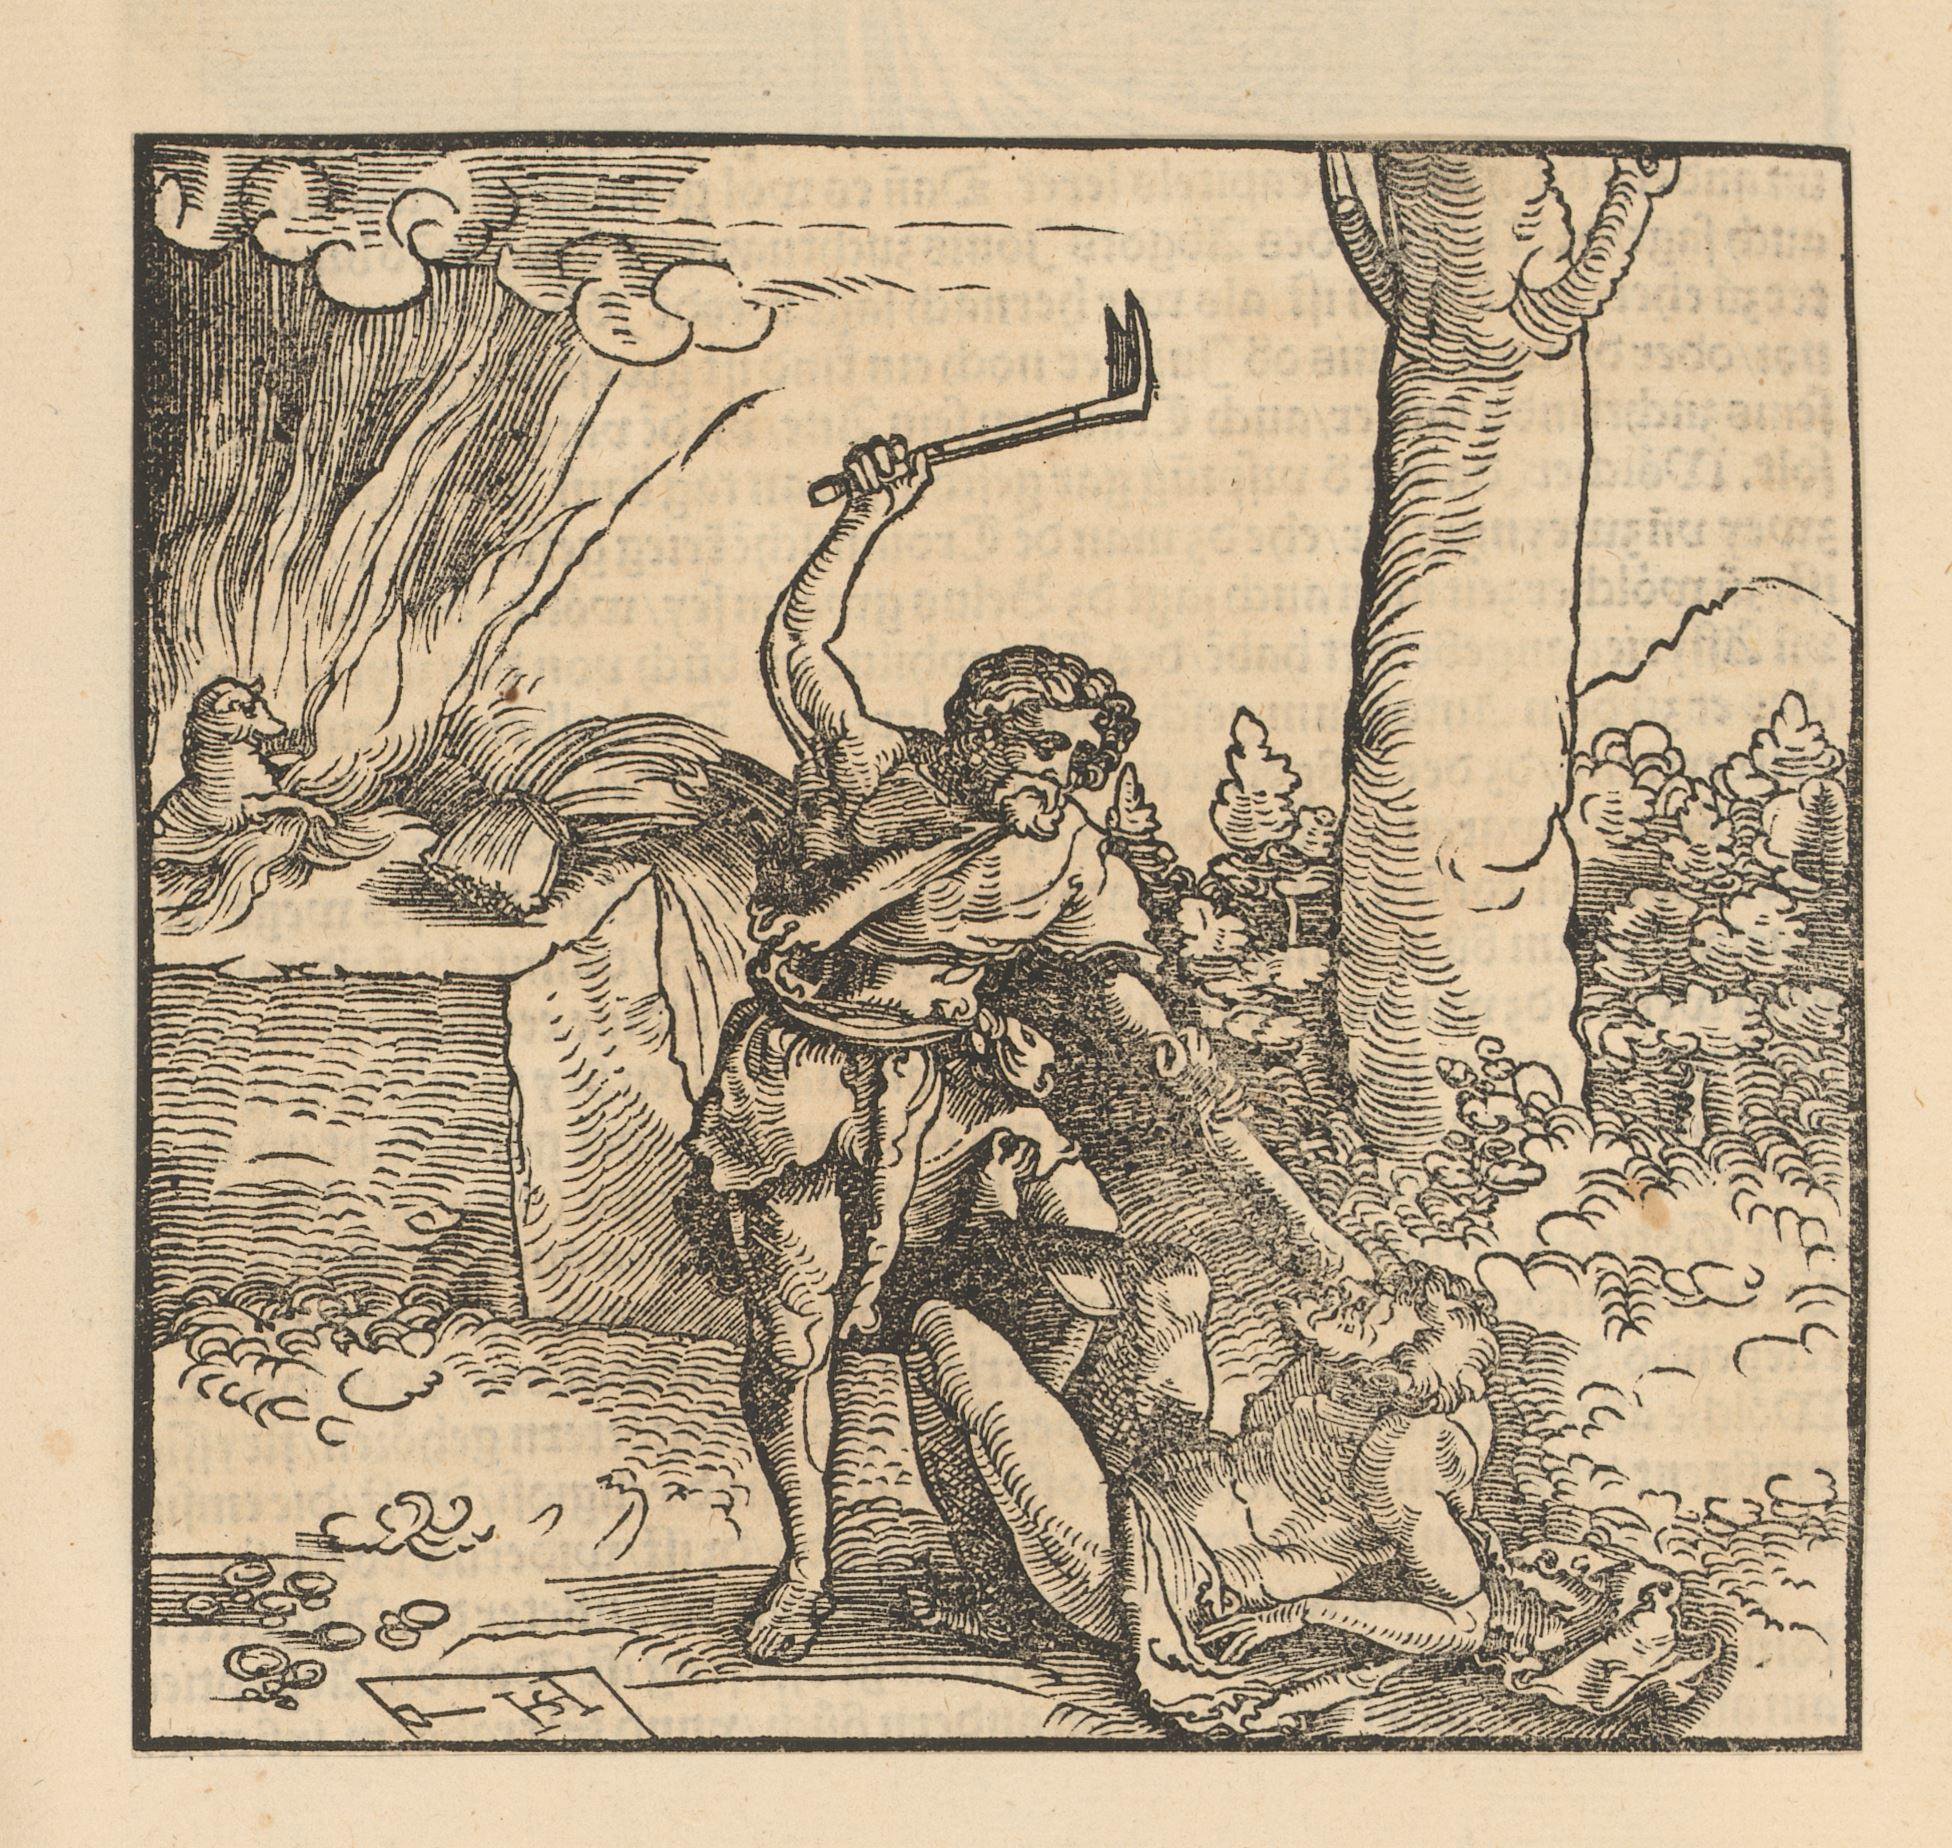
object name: book illustration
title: Kaïn doodt Abel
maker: hans schäufelein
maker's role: print maker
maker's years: 1480-1540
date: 1490-1538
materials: paper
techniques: letterpress printing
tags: the killing of abel: cain slays him with a stone, a club or a jaw-bone, alternatively with a spade or another tool as weapon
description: Tussen albumblad 37 en 38 is een stuk papier geplakt met daarop de handgeschreven tekst 'Cain die syn broeder Abel dood zal slaan gemaakt ~H', met daaronder 'Hans Schäufelein'.